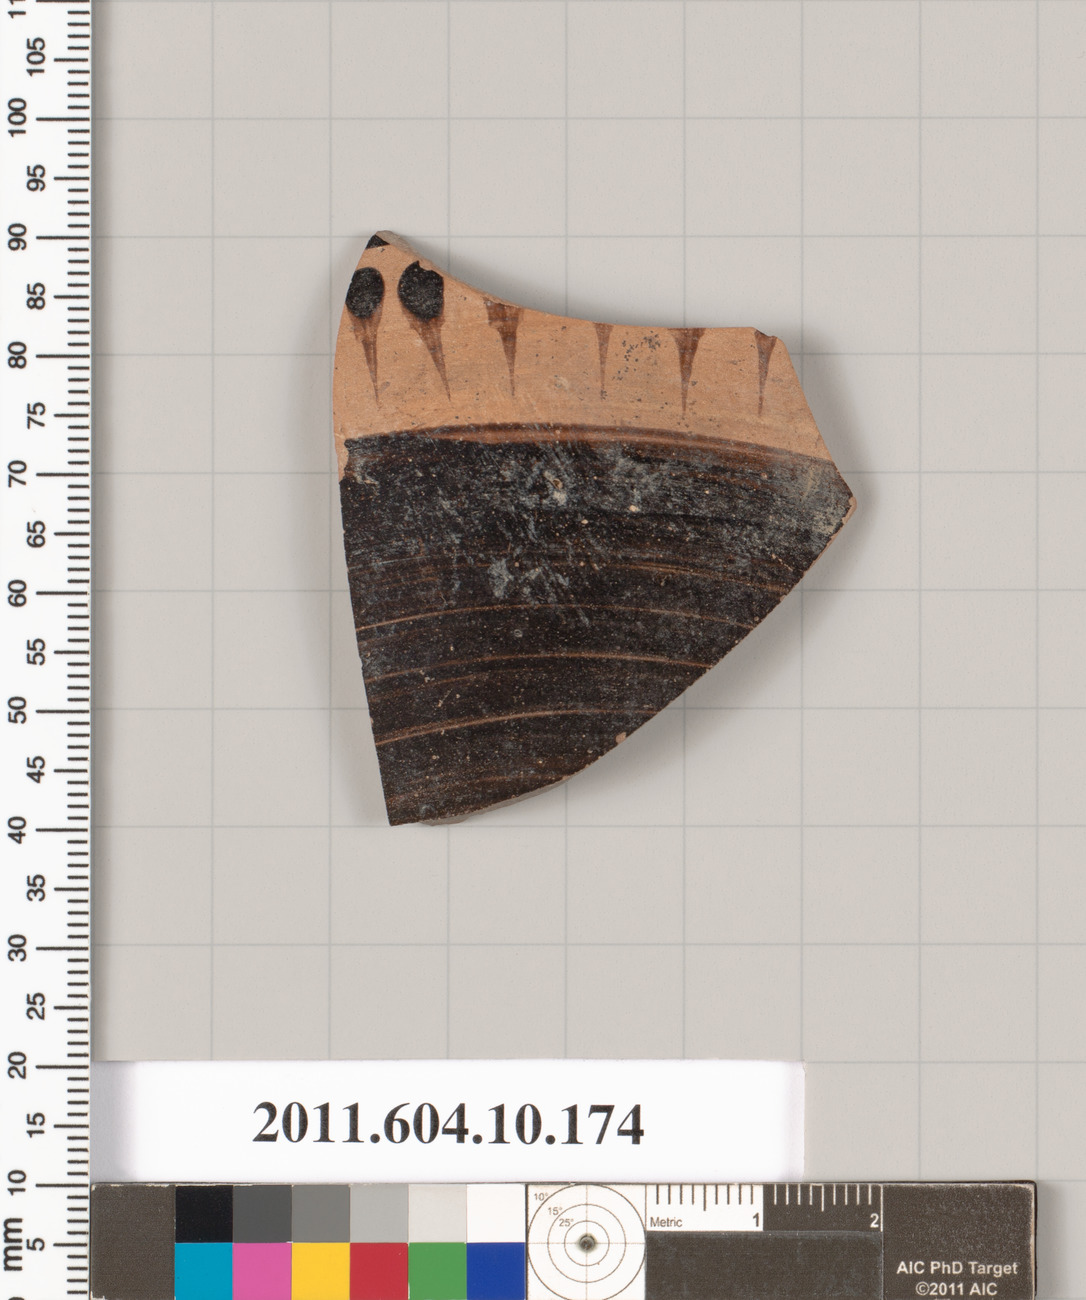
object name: skyphos fragment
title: Terracotta fragment of a skyphos (deep drinking cup)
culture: etruscan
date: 600-401 BCE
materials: terracotta